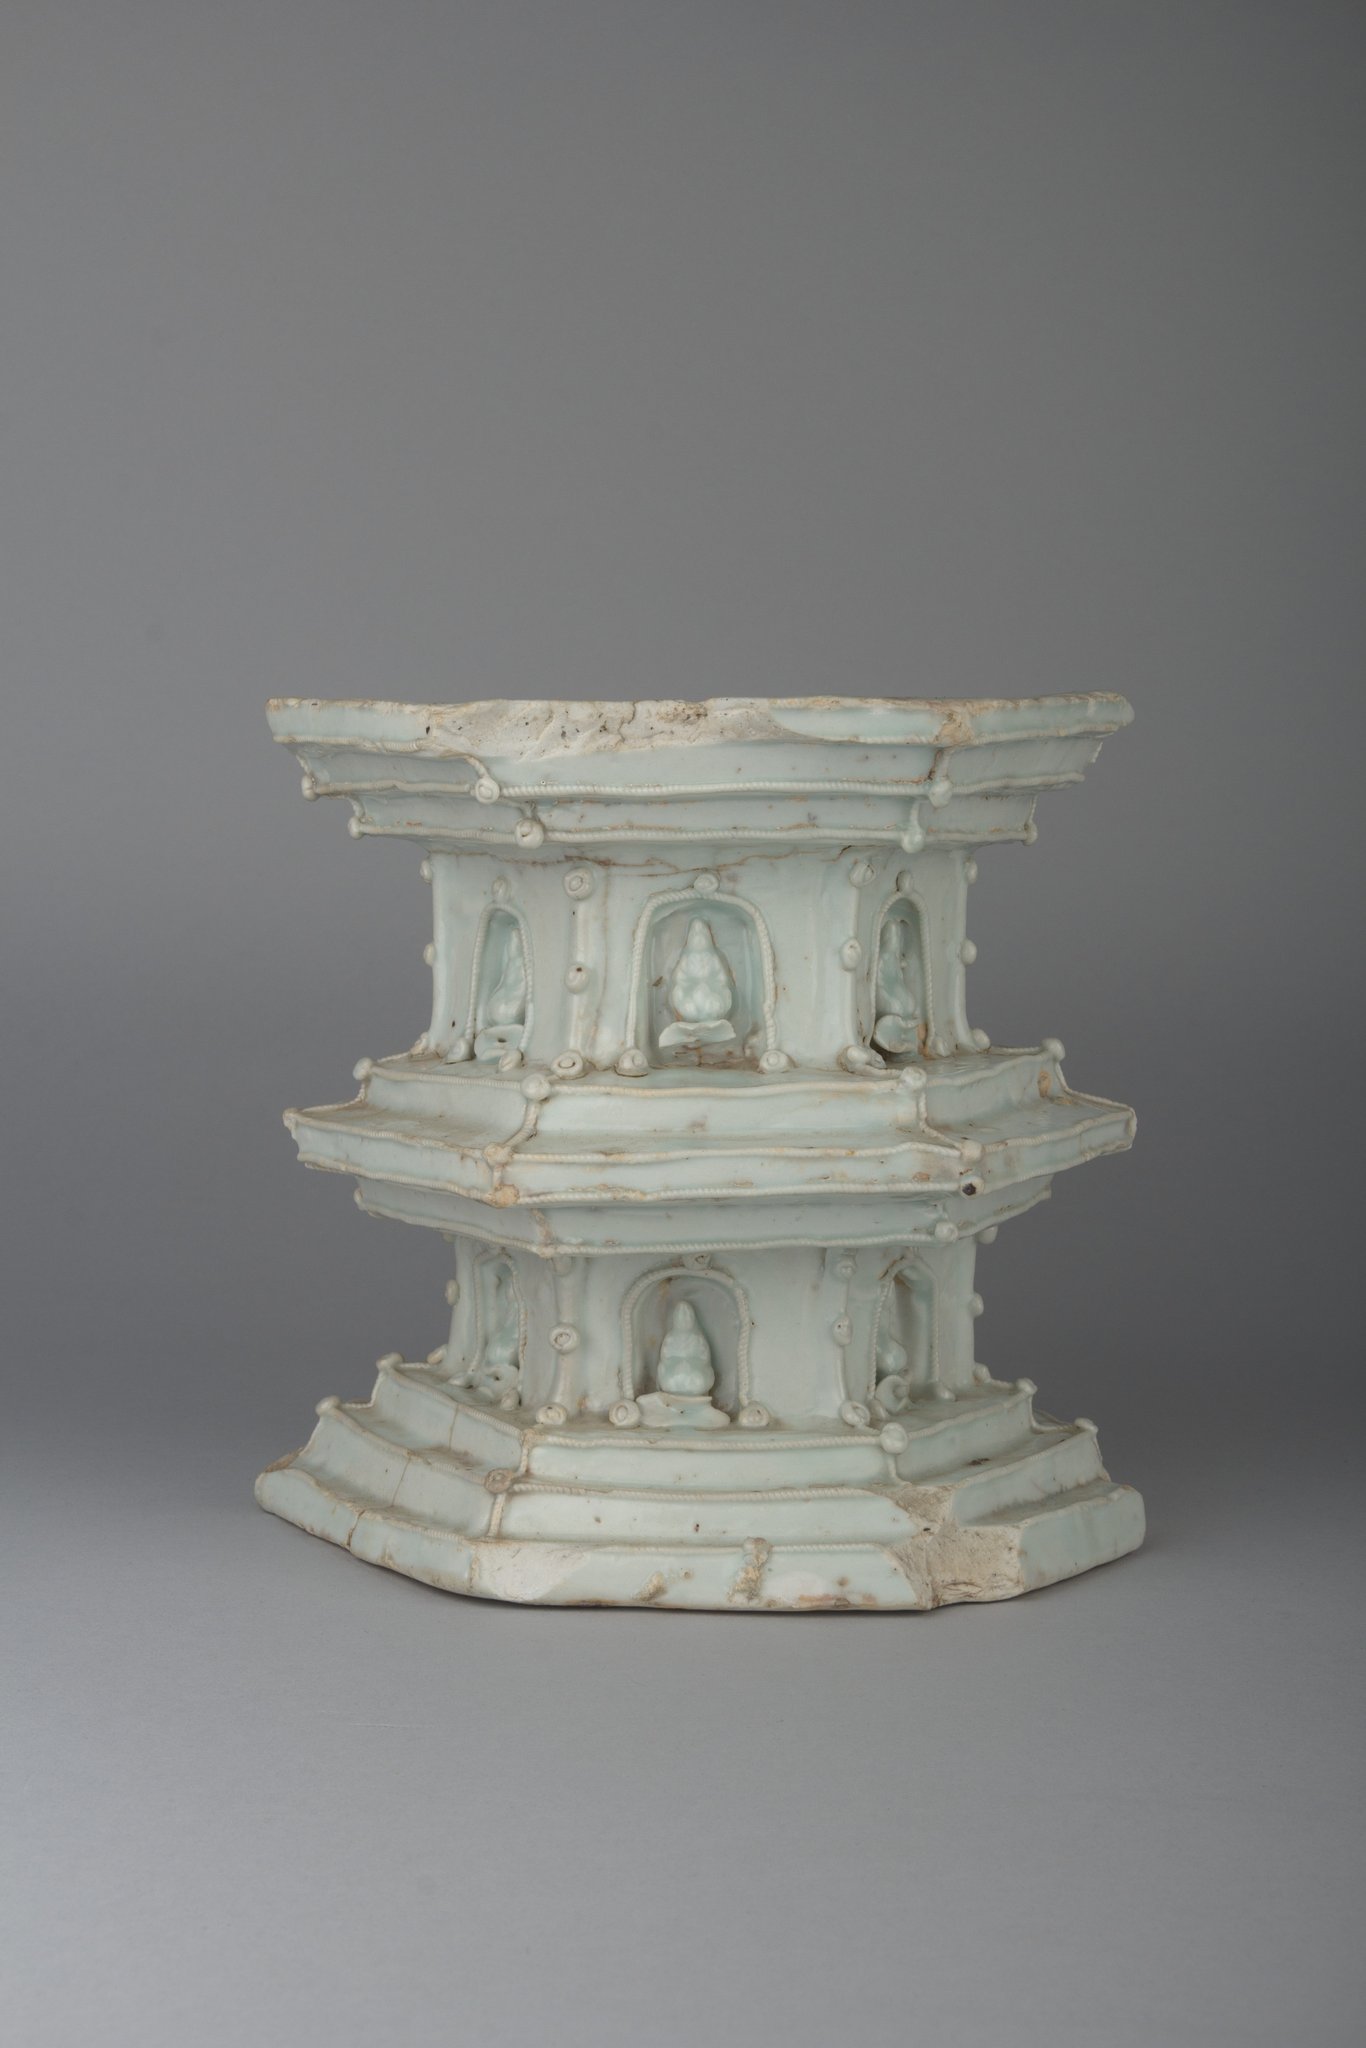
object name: pedestal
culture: chinese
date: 1301-1333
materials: glaze, porcelain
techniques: relief